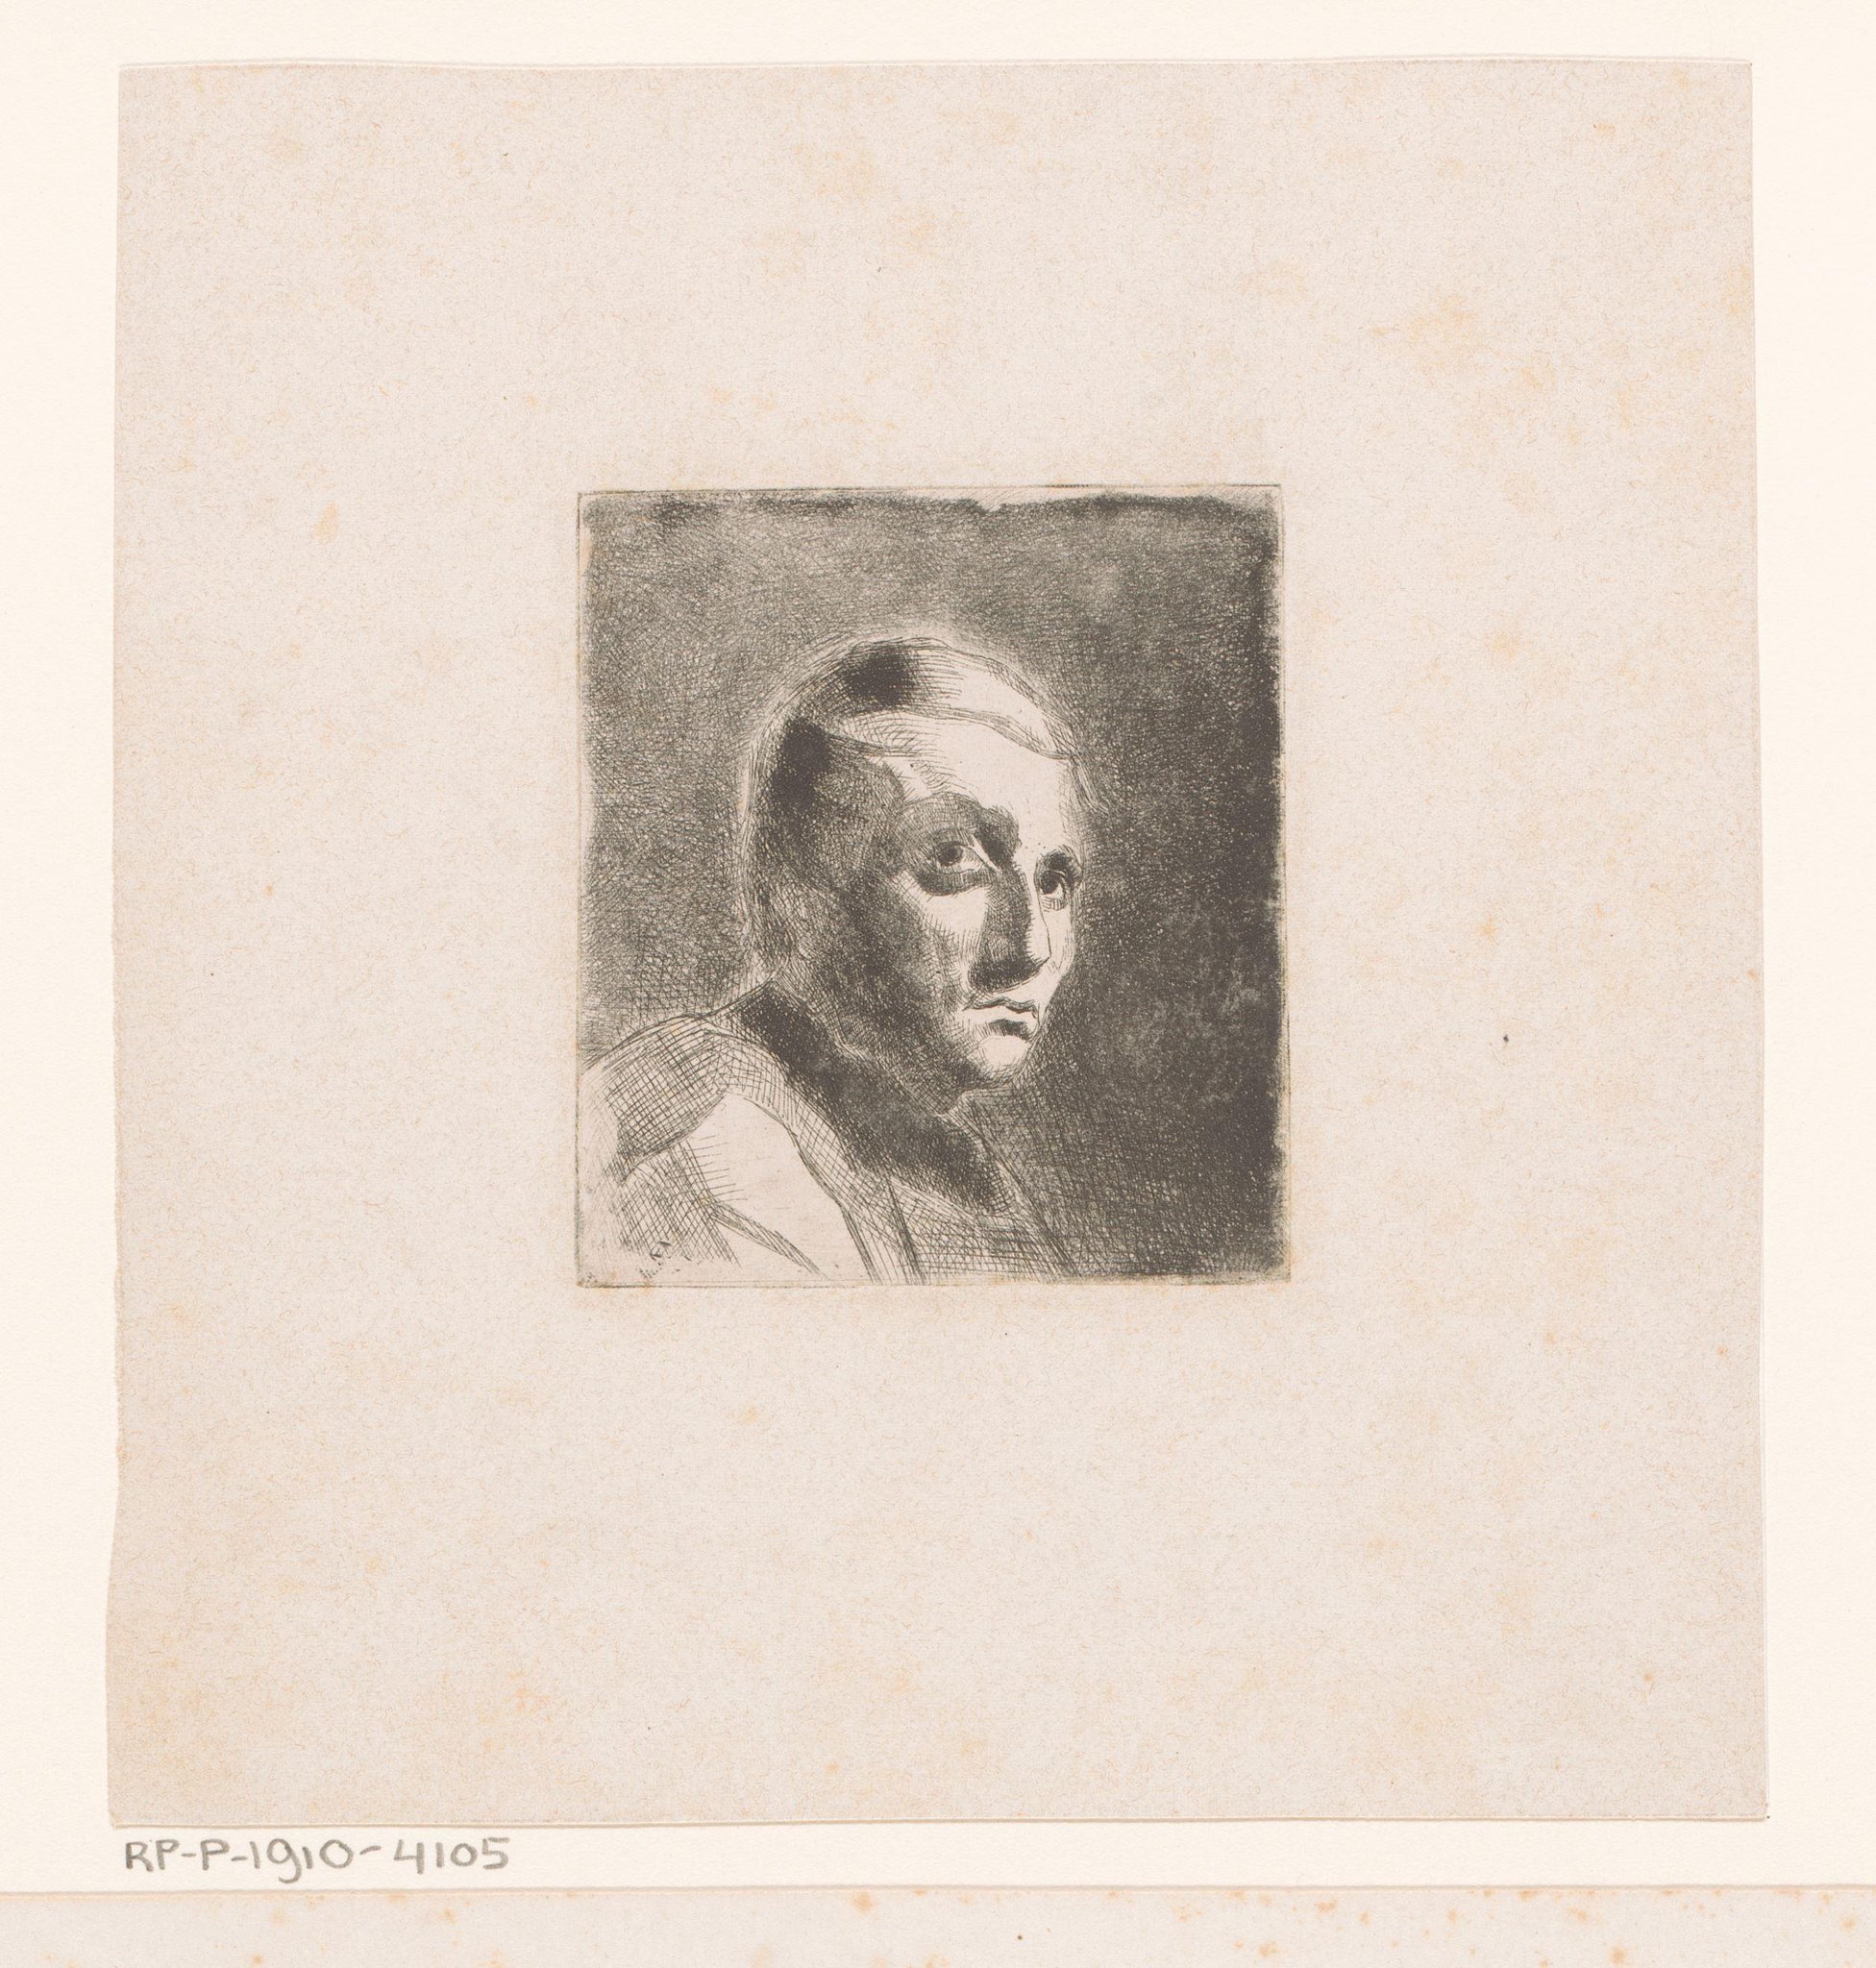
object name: print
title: Buste van een man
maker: Anonymous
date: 1850-1910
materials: paper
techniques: etching, retroussage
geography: belgium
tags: adult man (+ three-quarter view)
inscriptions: collector's mark: Lugt 2228, annotation: ‘A.A.’